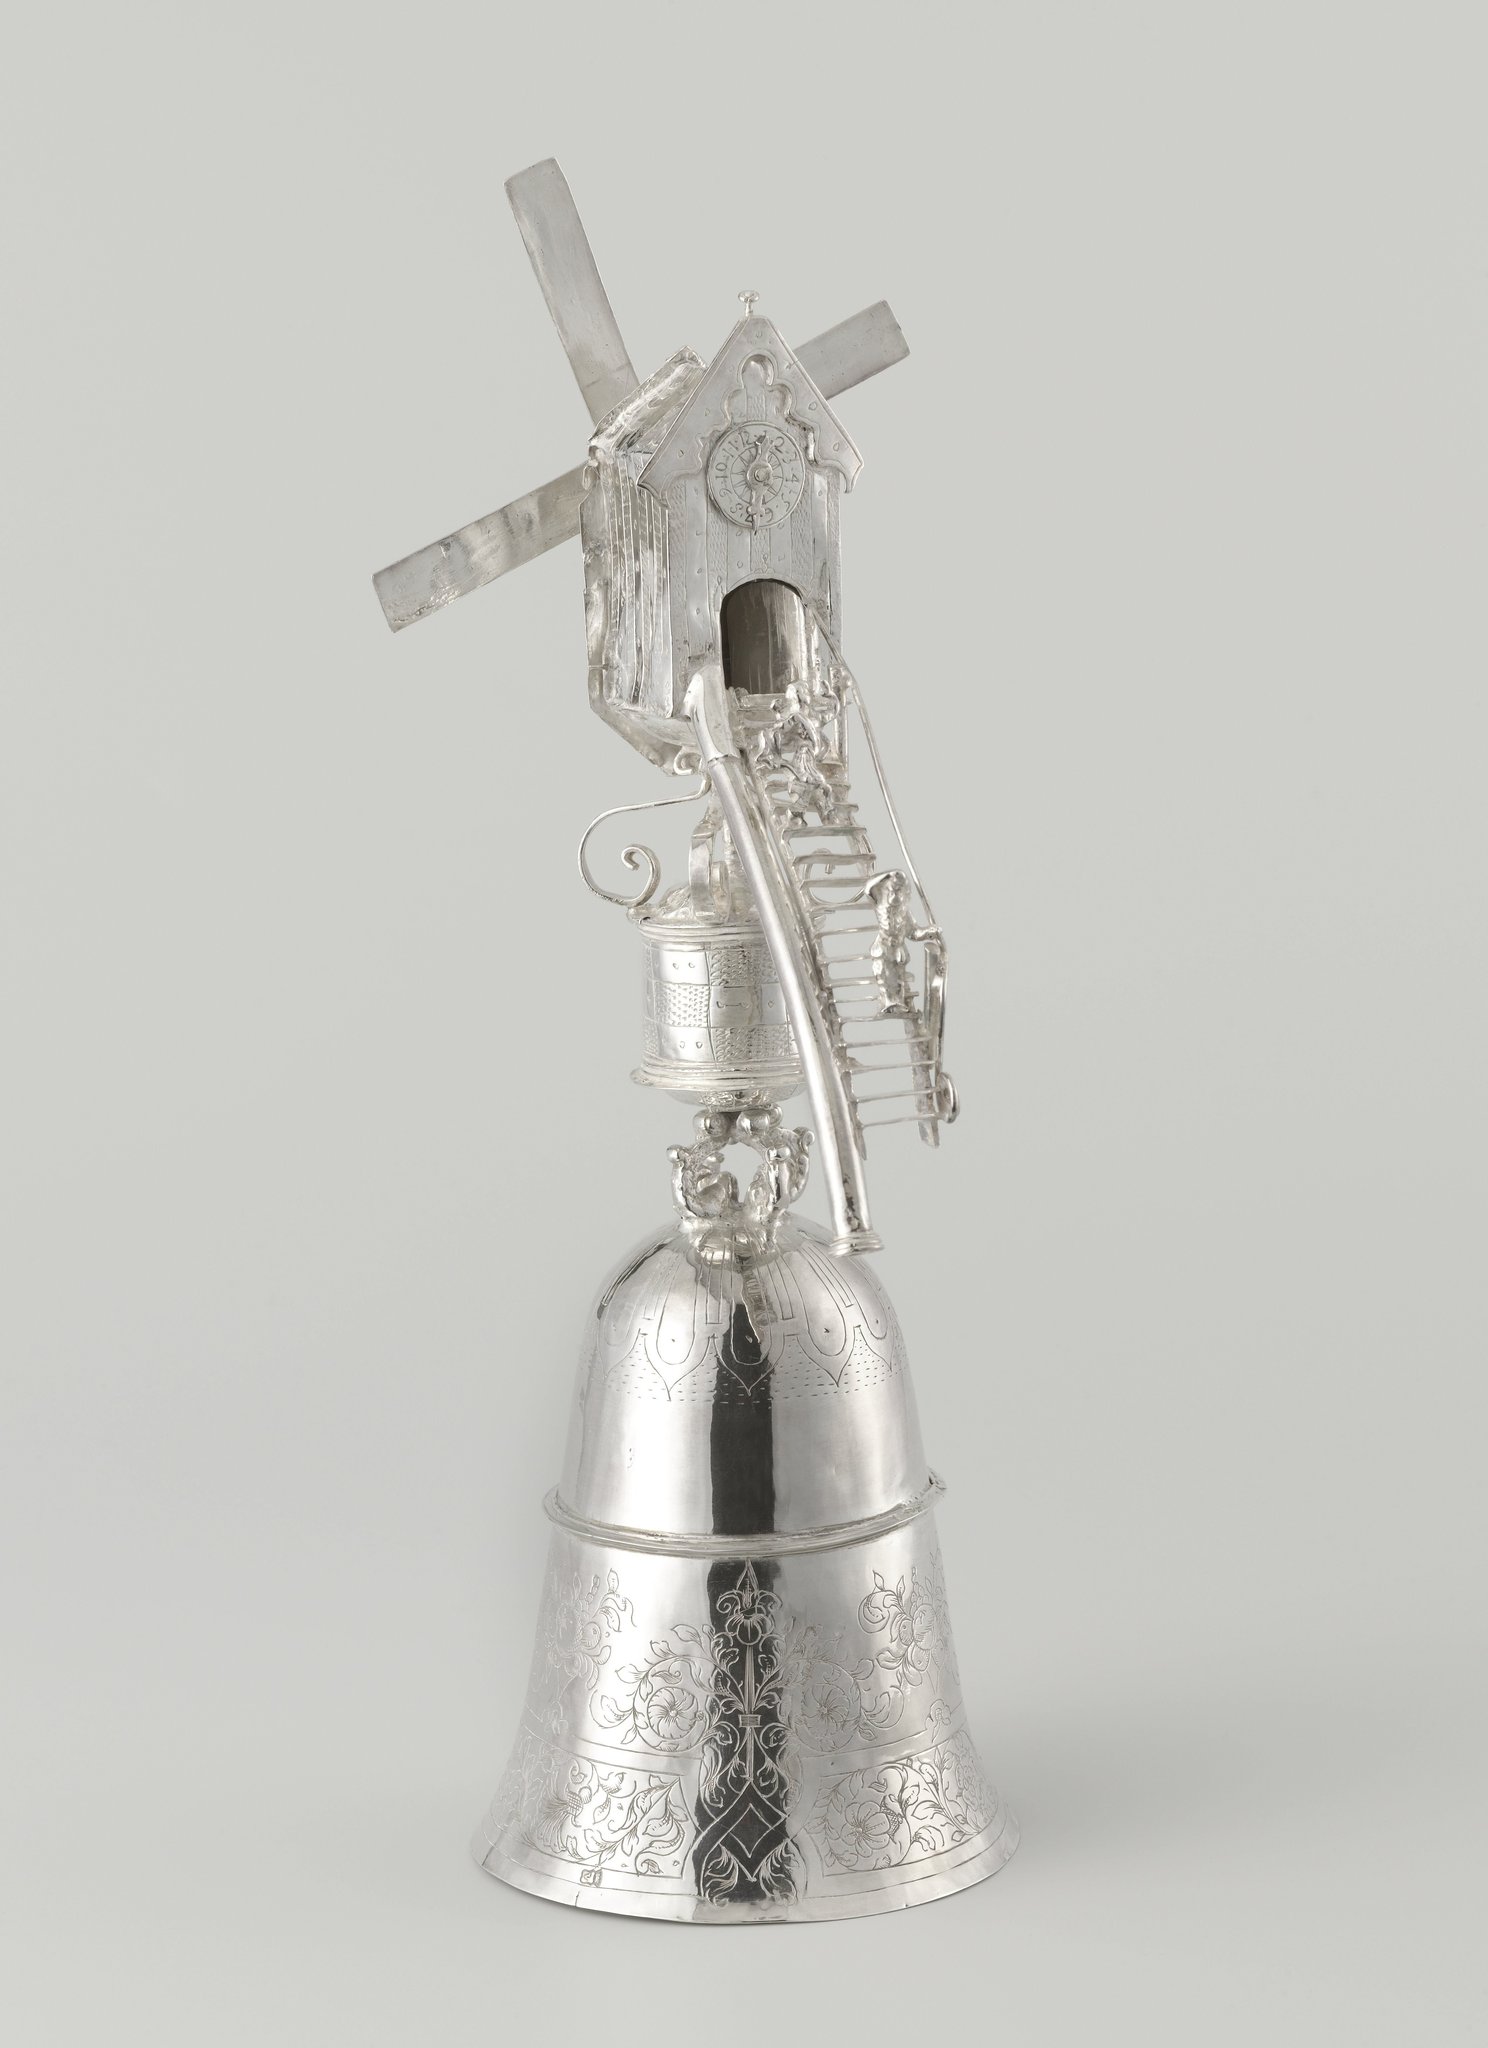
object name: fantasiebeker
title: Windmill cup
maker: Anonymous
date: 1650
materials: silver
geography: dordrecht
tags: windmill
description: By blowing into the pipe attached to the windmill, the drinker set the sails in motion. On the back of the windmill is a dial with twelve numbers. The rules of play for using this cup are not known. Did the drinker have to drain the cup before the sails stopped spinning? And did the dial indicate whose turn it was next?